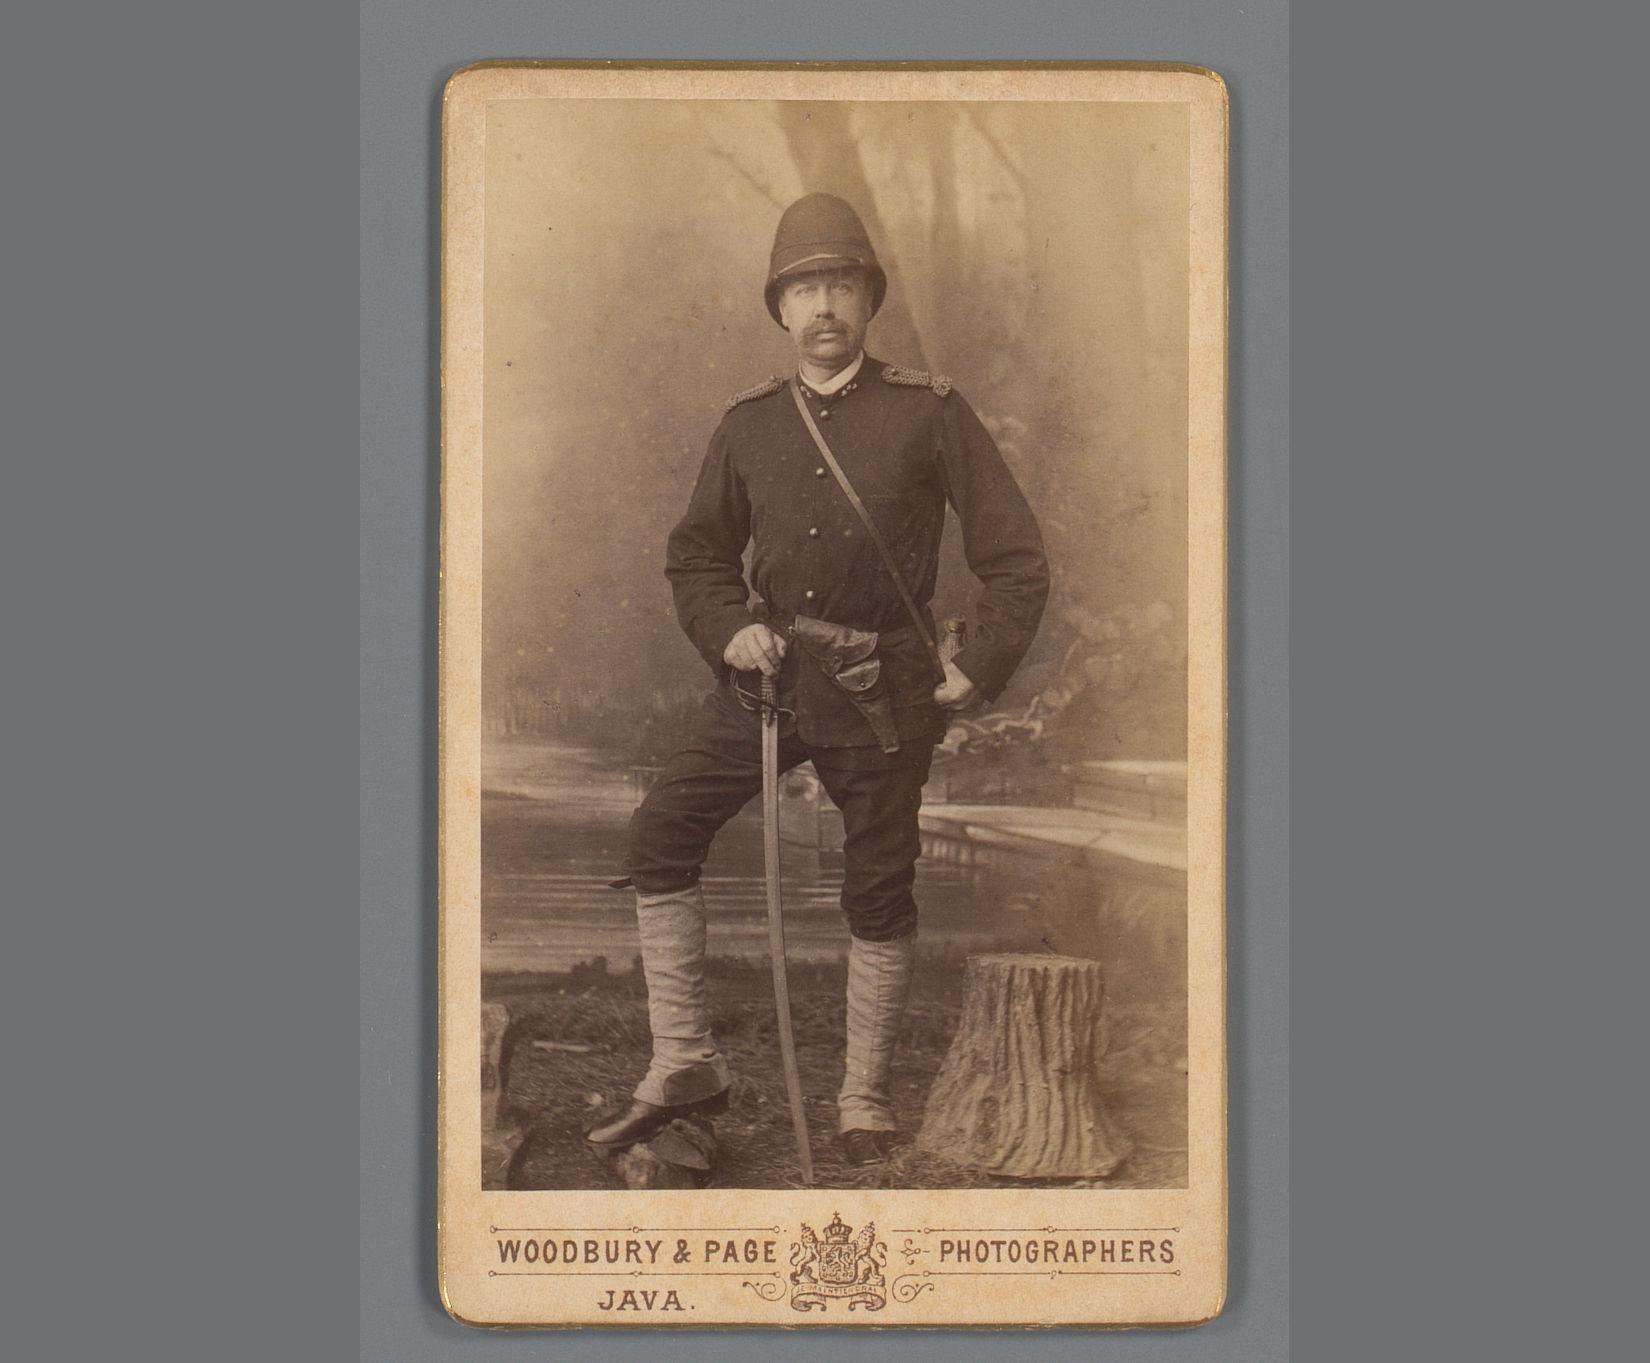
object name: carte de visite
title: Portret van een onbekende man in een militair uniform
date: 1860-1880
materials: cardboard, paper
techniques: albumen print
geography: java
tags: (military) uniforms, historical persons not known by name, java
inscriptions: inscription: ‘Woodbury & Page/ Photographers/ Java.’